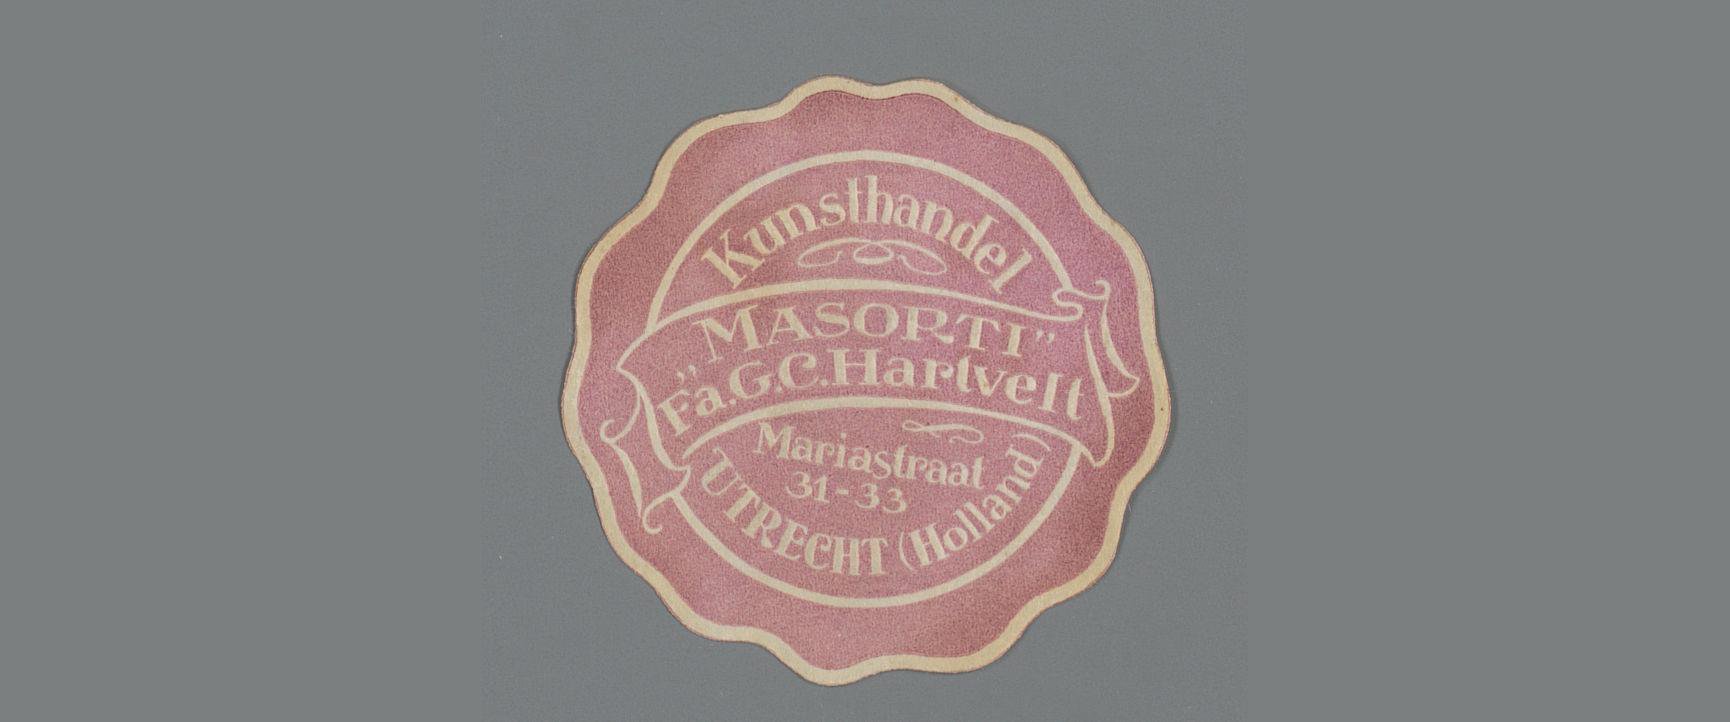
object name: label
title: Etiket van kunsthandel 'Masorti', firma G.C. Hartvelt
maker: Anonymous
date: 1900-1940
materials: paper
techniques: blind stamped, lithograph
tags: visiting-card, calling-card, utrecht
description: Bij gebrek aan gegevens over de vervaardiger is voor de bepaling van de rechten van dit object gebruik gemaakt van de (geschatte) vervaardigingsdatum.